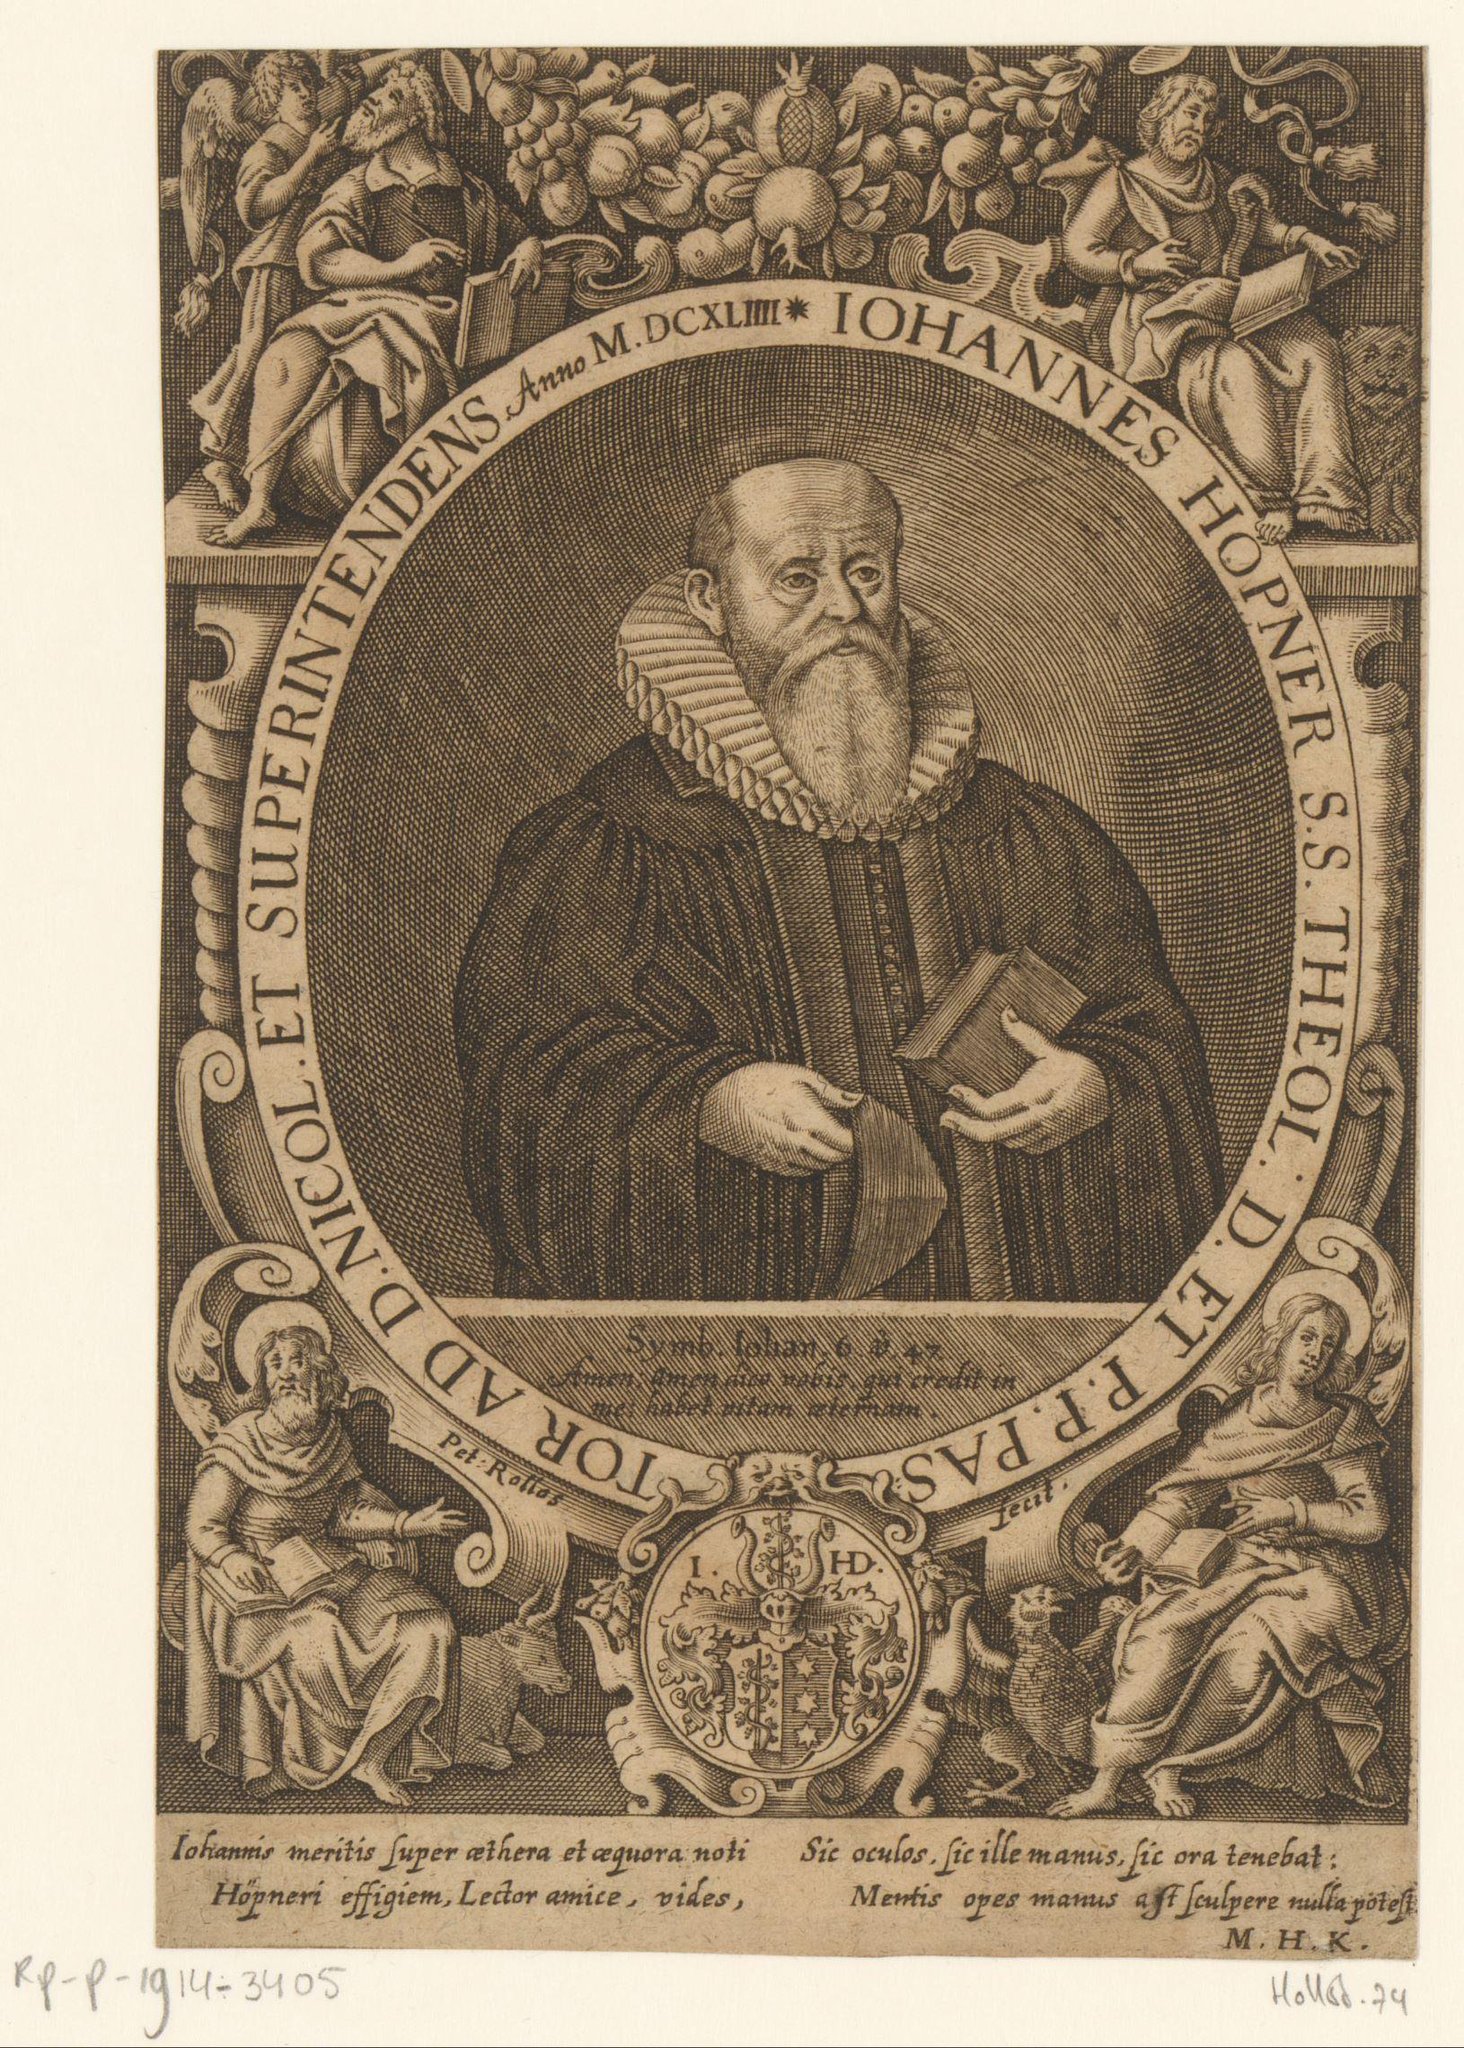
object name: print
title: Portret van Johannes Höpner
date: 1644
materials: paper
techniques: engraving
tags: theologian, the four evangelists together (author portraits), historical persons, armorial bearing, heraldry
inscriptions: collector's mark: Lugt 2228